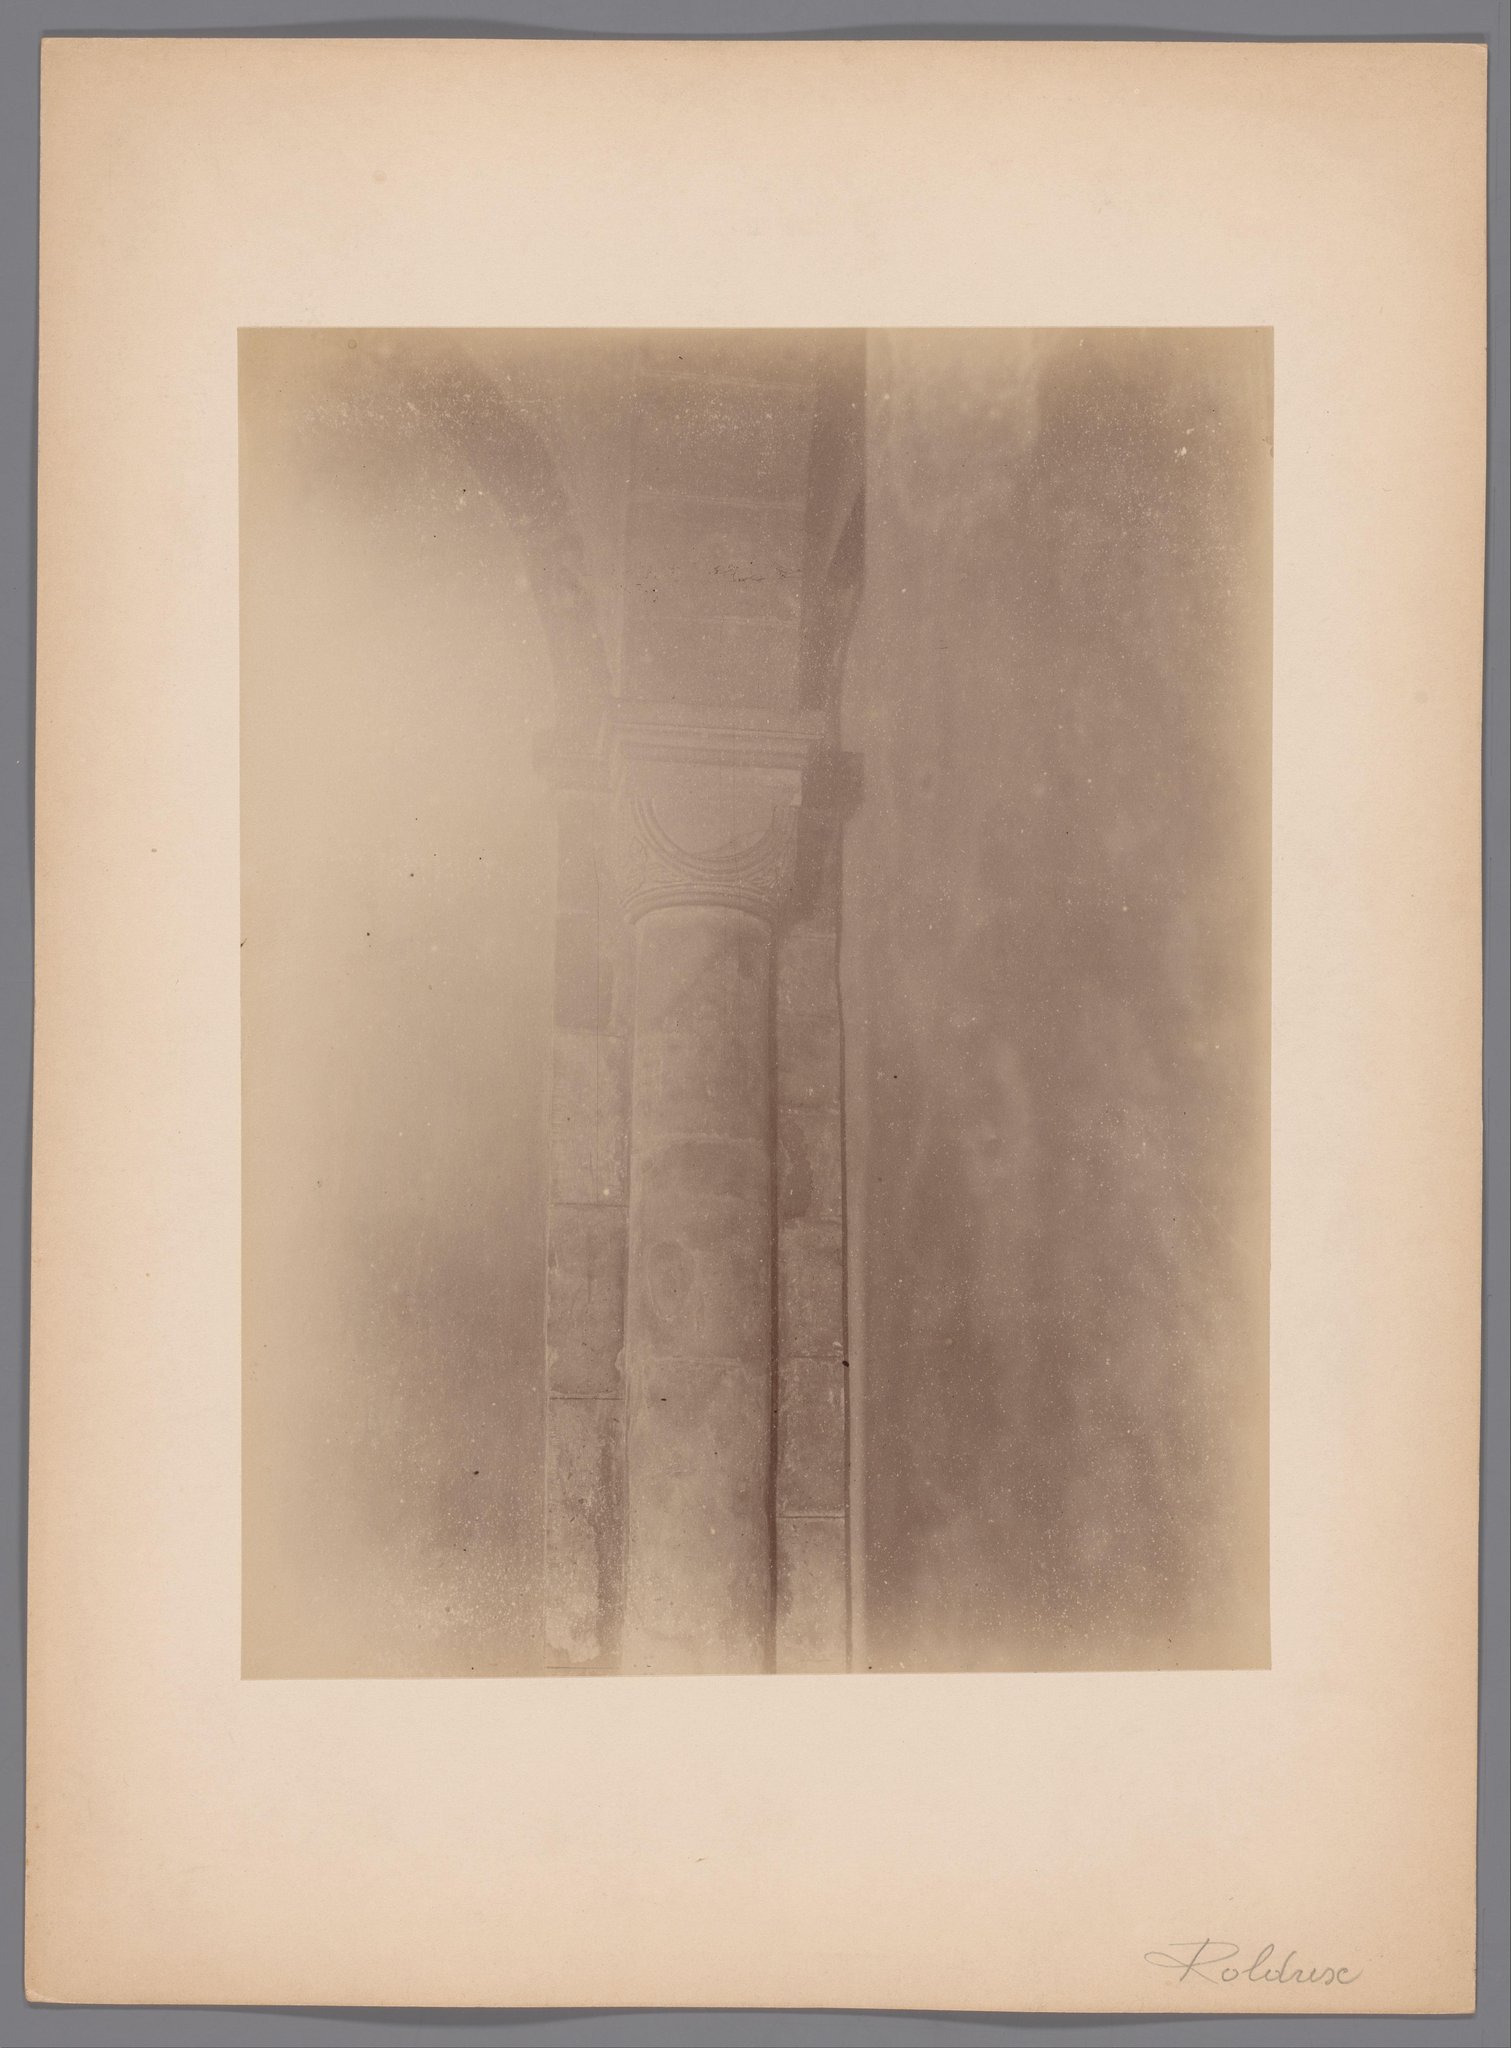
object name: photograph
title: Kapiteel van een wandpijler in de Abdijkerk Rolduc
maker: anoniem (monumentenzorg)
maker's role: fotograaf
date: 1890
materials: cardboard, photographic support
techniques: albumen print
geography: rolduc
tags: capital (~ column, pillar)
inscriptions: annotation: ‘Kapiteel van een der wandpijlers in de kerk te Rolduc/ oct 1890’, annotation: ‘Rolduc’